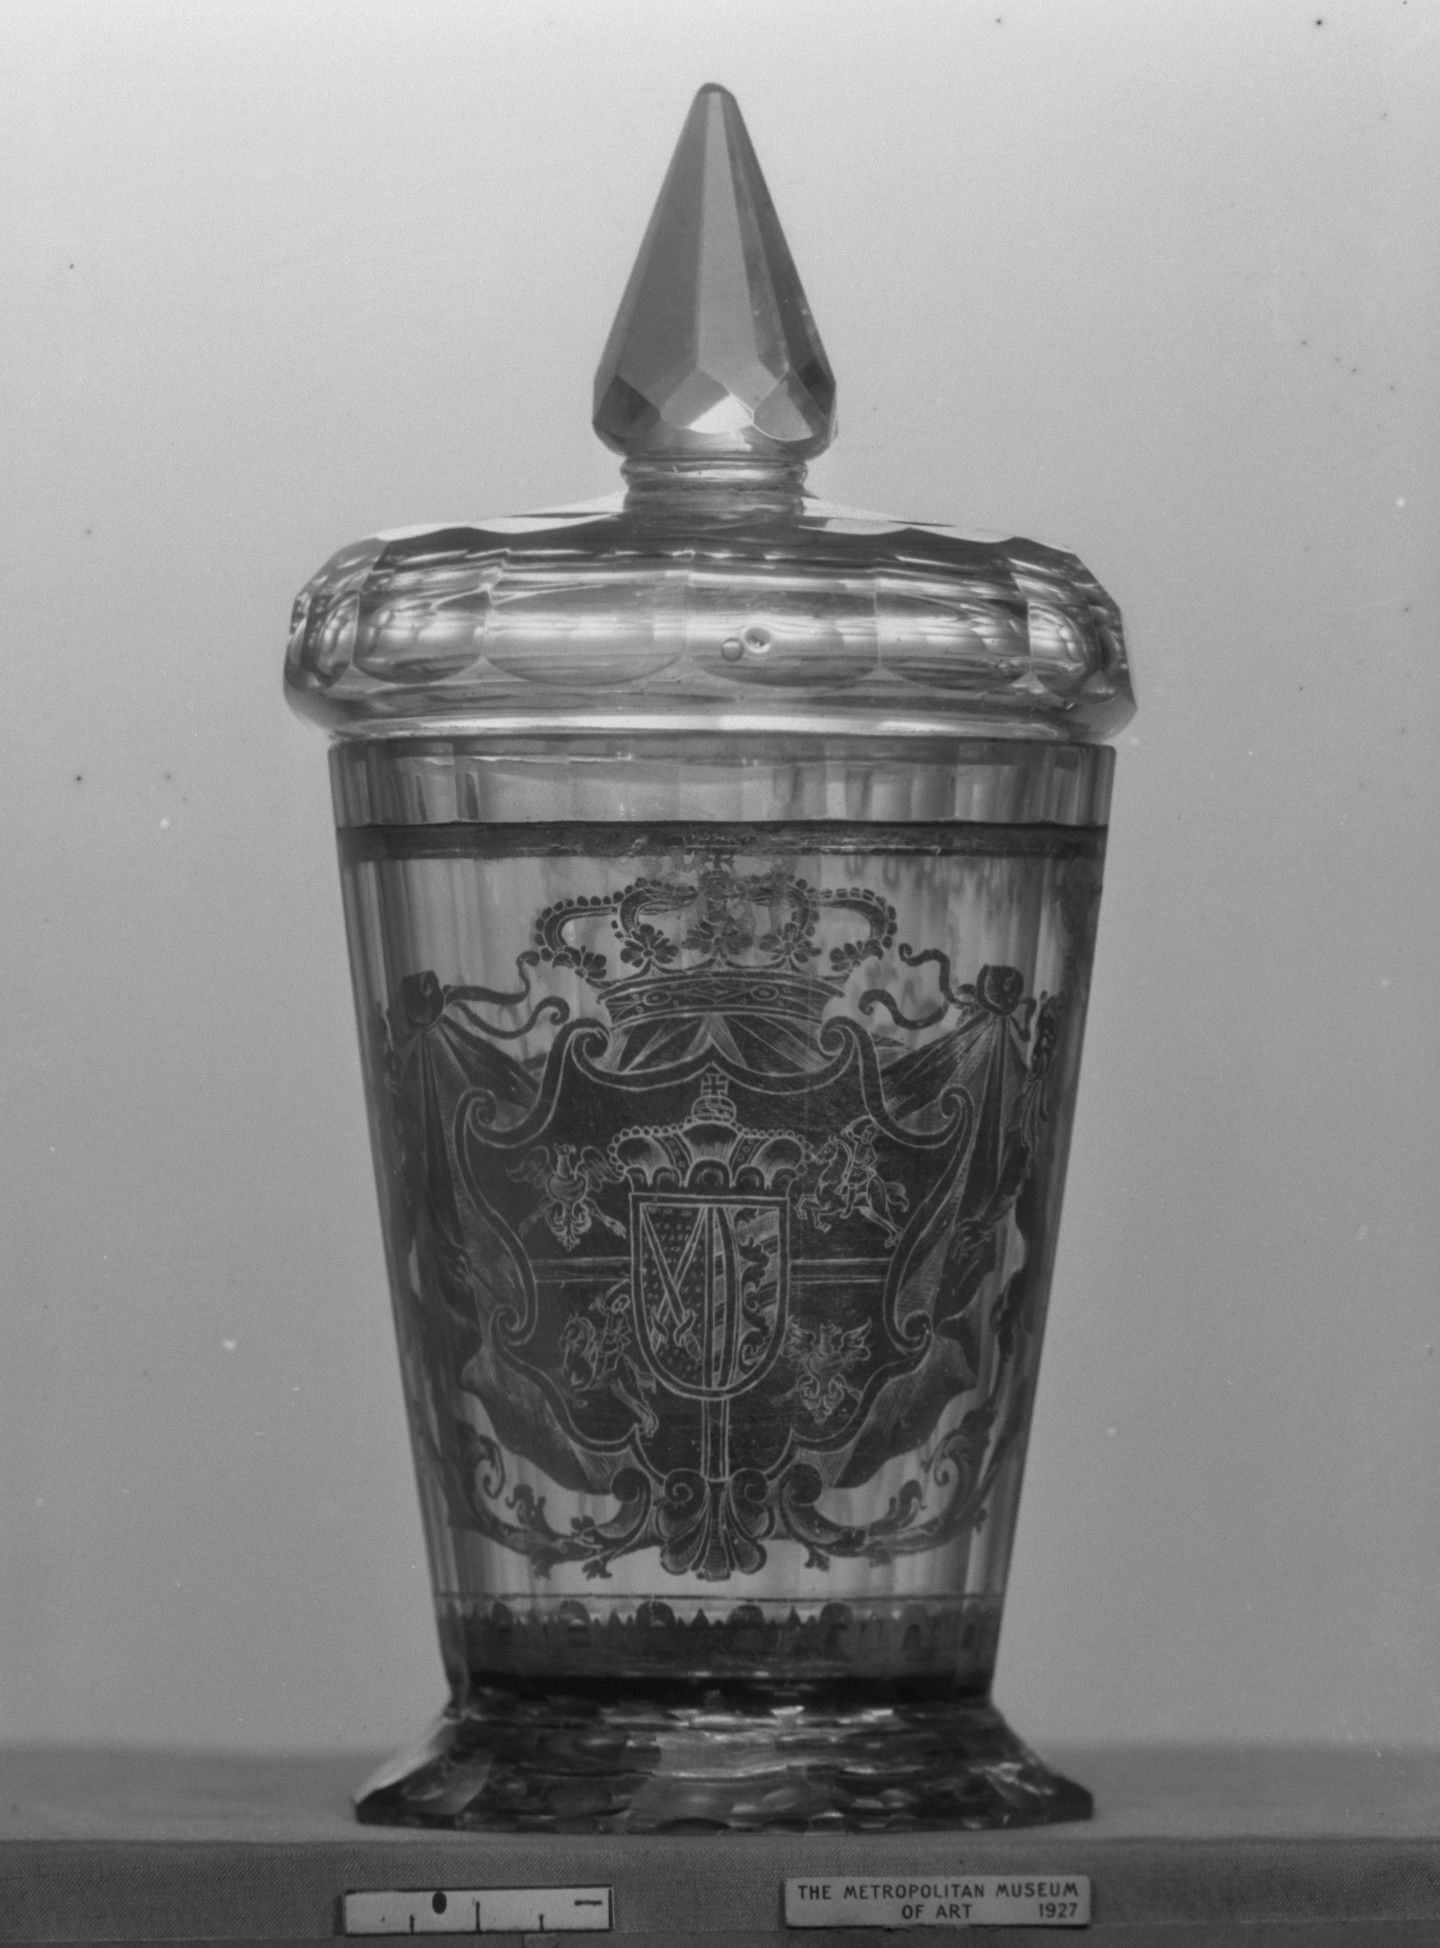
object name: beaker with cover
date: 1730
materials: glass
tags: coat of arms